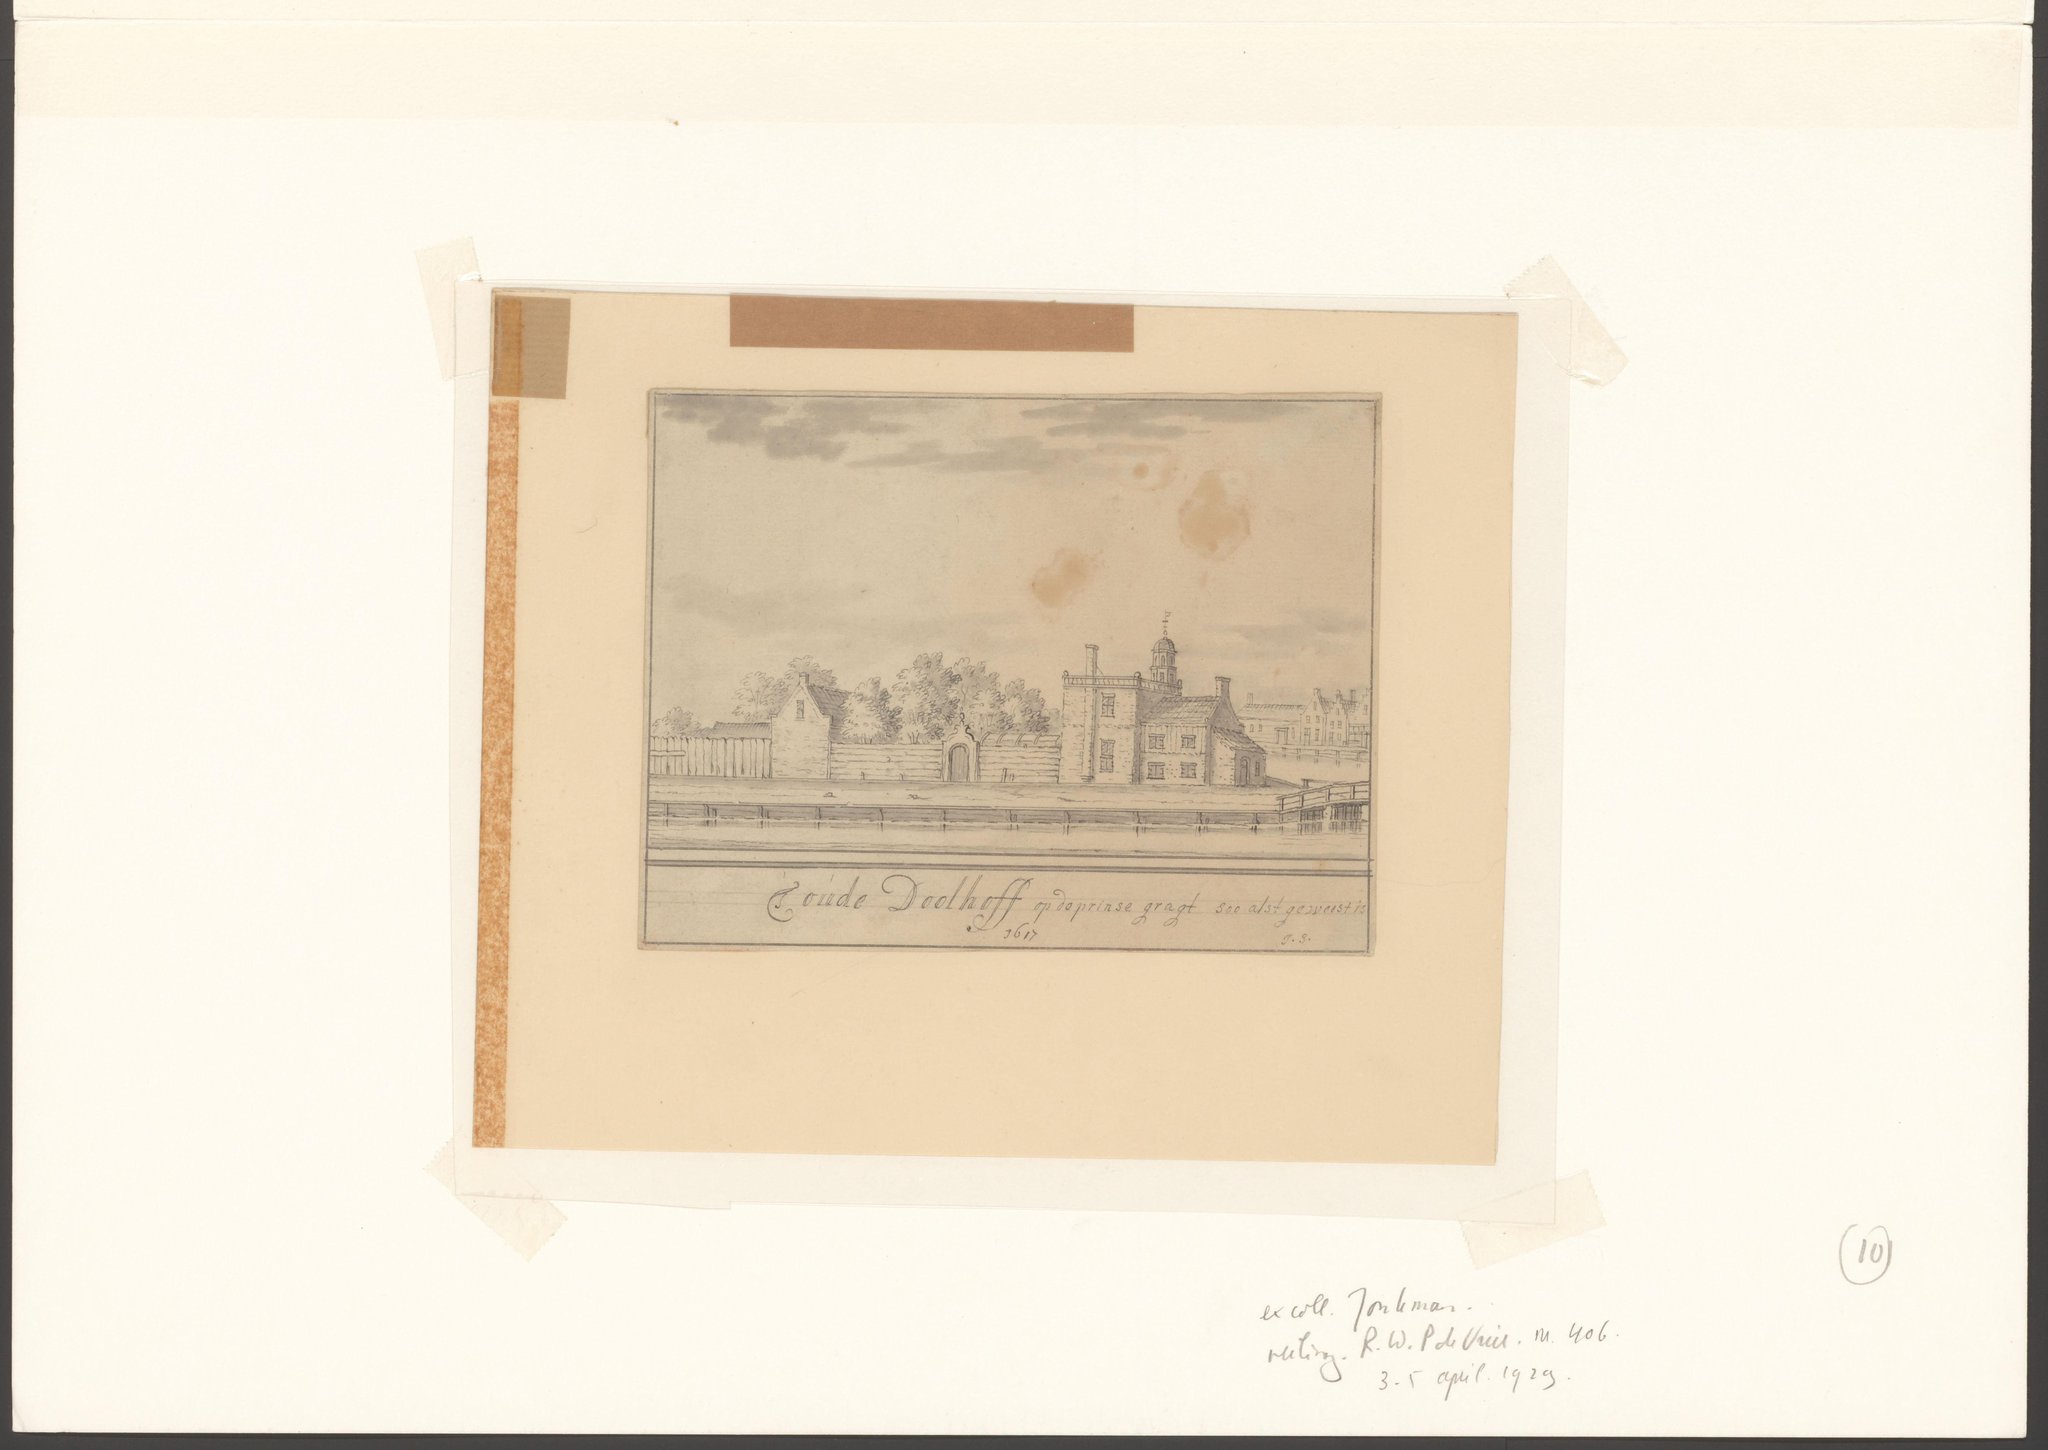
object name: drawing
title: Gezicht op het oude Doolhof op de Prinsengracht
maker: jacobus stellingwerff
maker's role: draughtsman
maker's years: 1660-1736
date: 1670-1736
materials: ink, paper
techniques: brush, pen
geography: amsterdam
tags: city-view in general; 'veduta', labyrinth, maze ~ garden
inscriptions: inscription: ‘T oude Doolhoff op de prinse gragt soo alst geweest is / 1617’, signature: ‘J.S.’, inscription: ‘ex. coll. Jonkman / veiling. R.W.P de Vries, n. 406. / 3-5 april. 1929. / 10’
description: Onderwerpsrubriek binnen de Atlas Amsterdam: Doolhof.